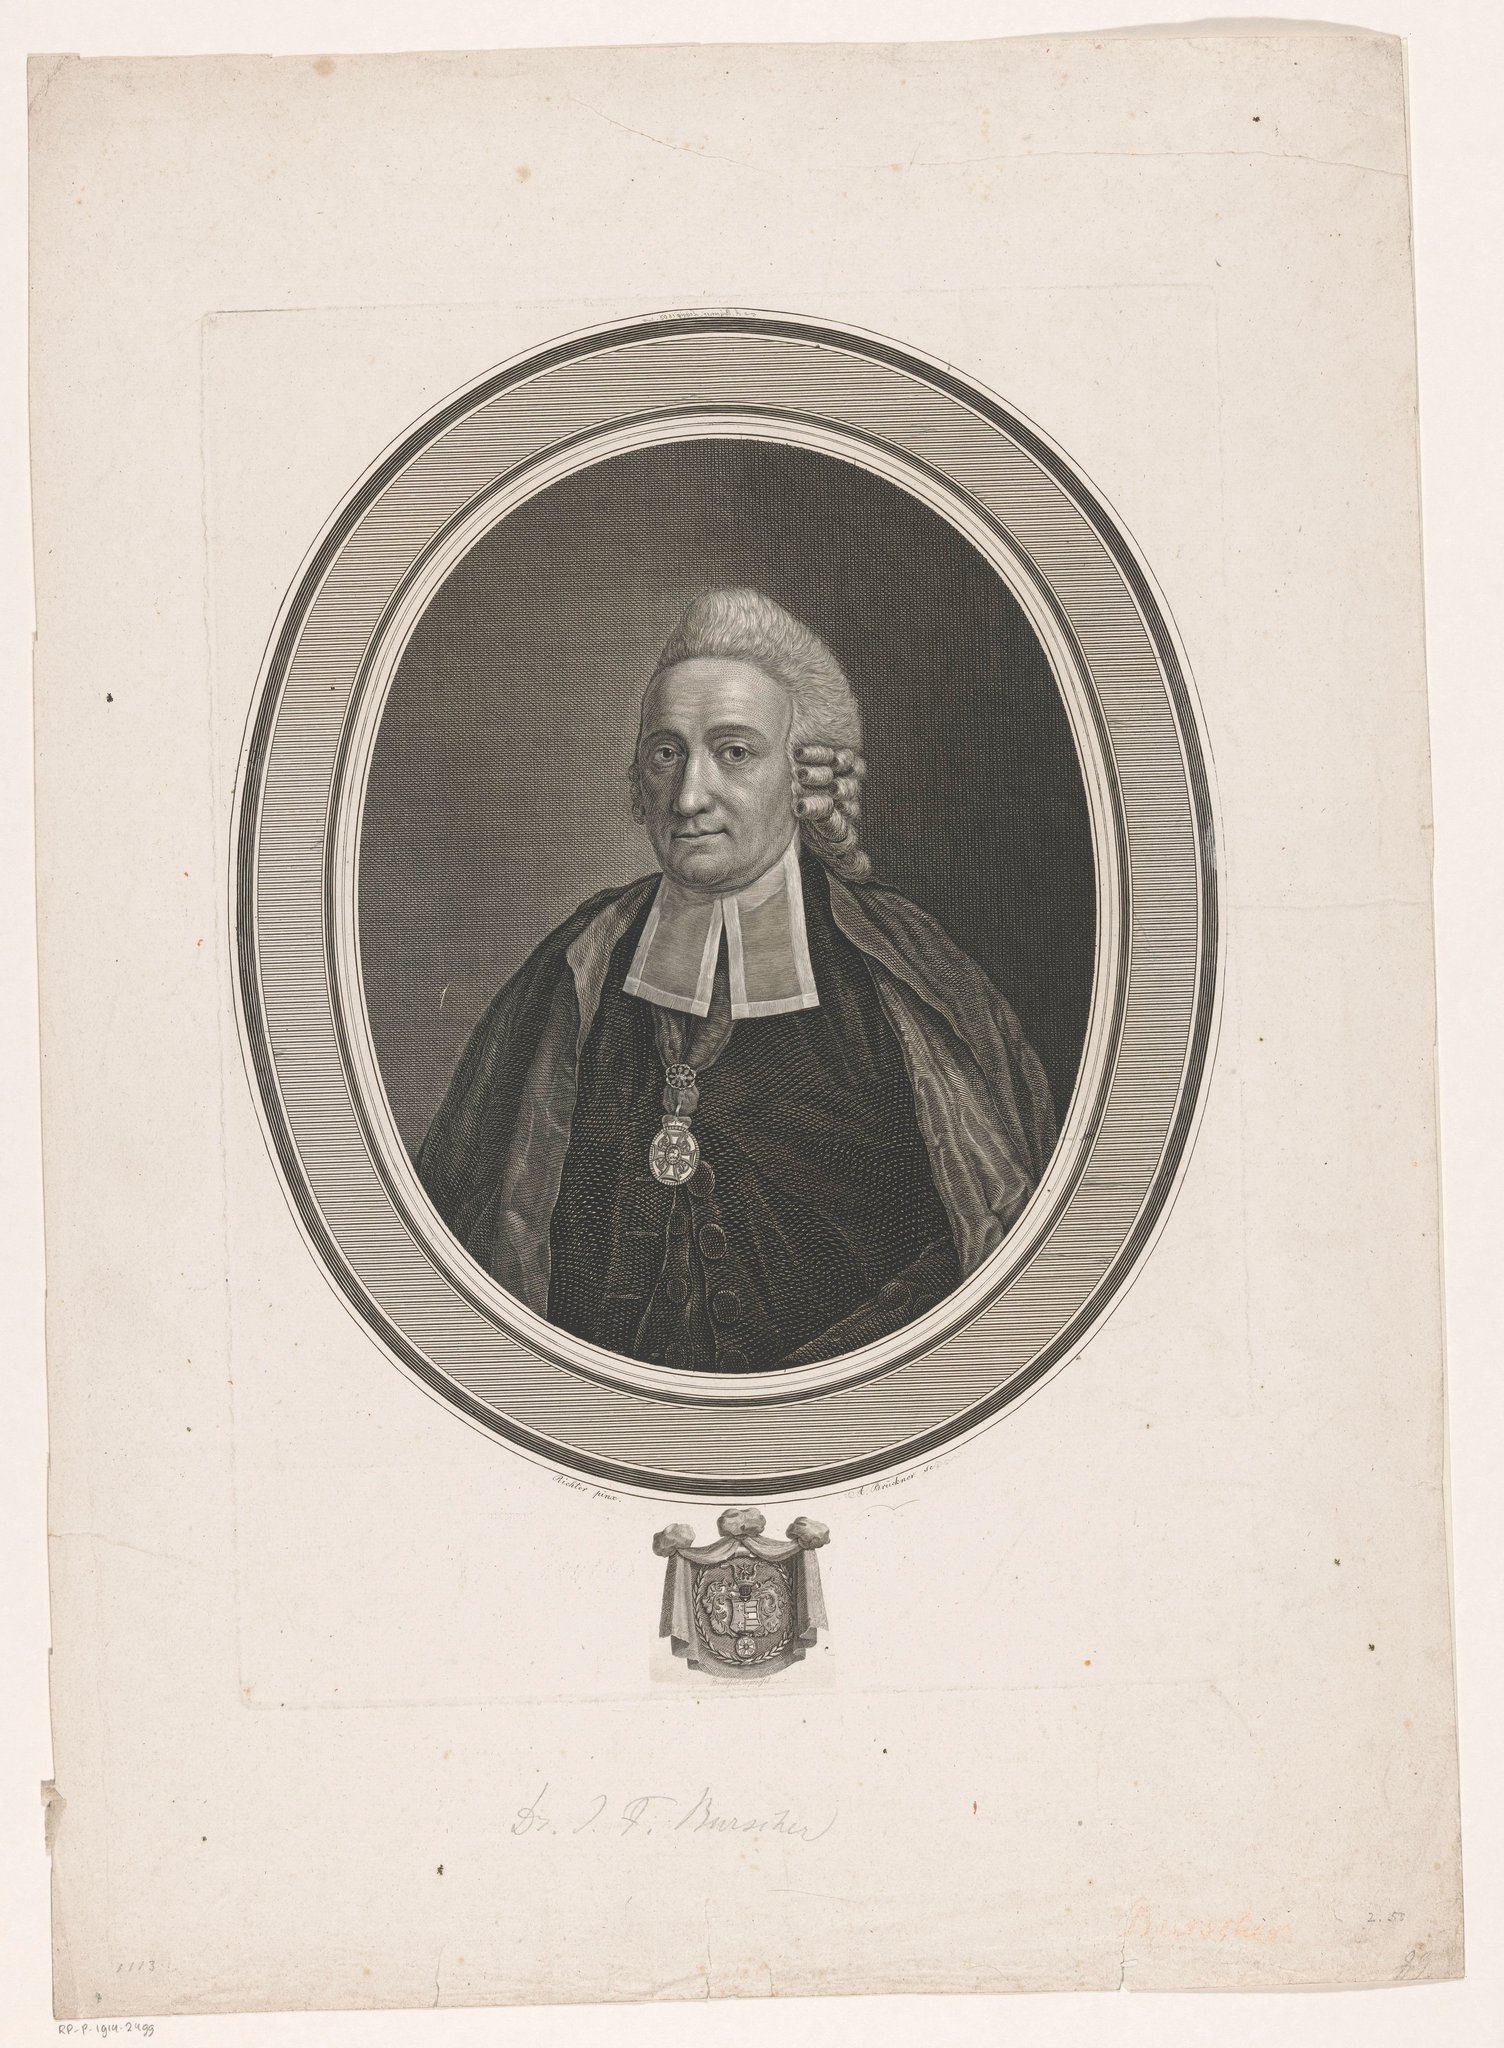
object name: print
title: Portret van Johann Friedrich Burscher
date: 1795-1814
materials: paper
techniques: engraving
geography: leipzig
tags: historical persons, armorial bearing, heraldry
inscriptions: collector's mark: Lugt 2228